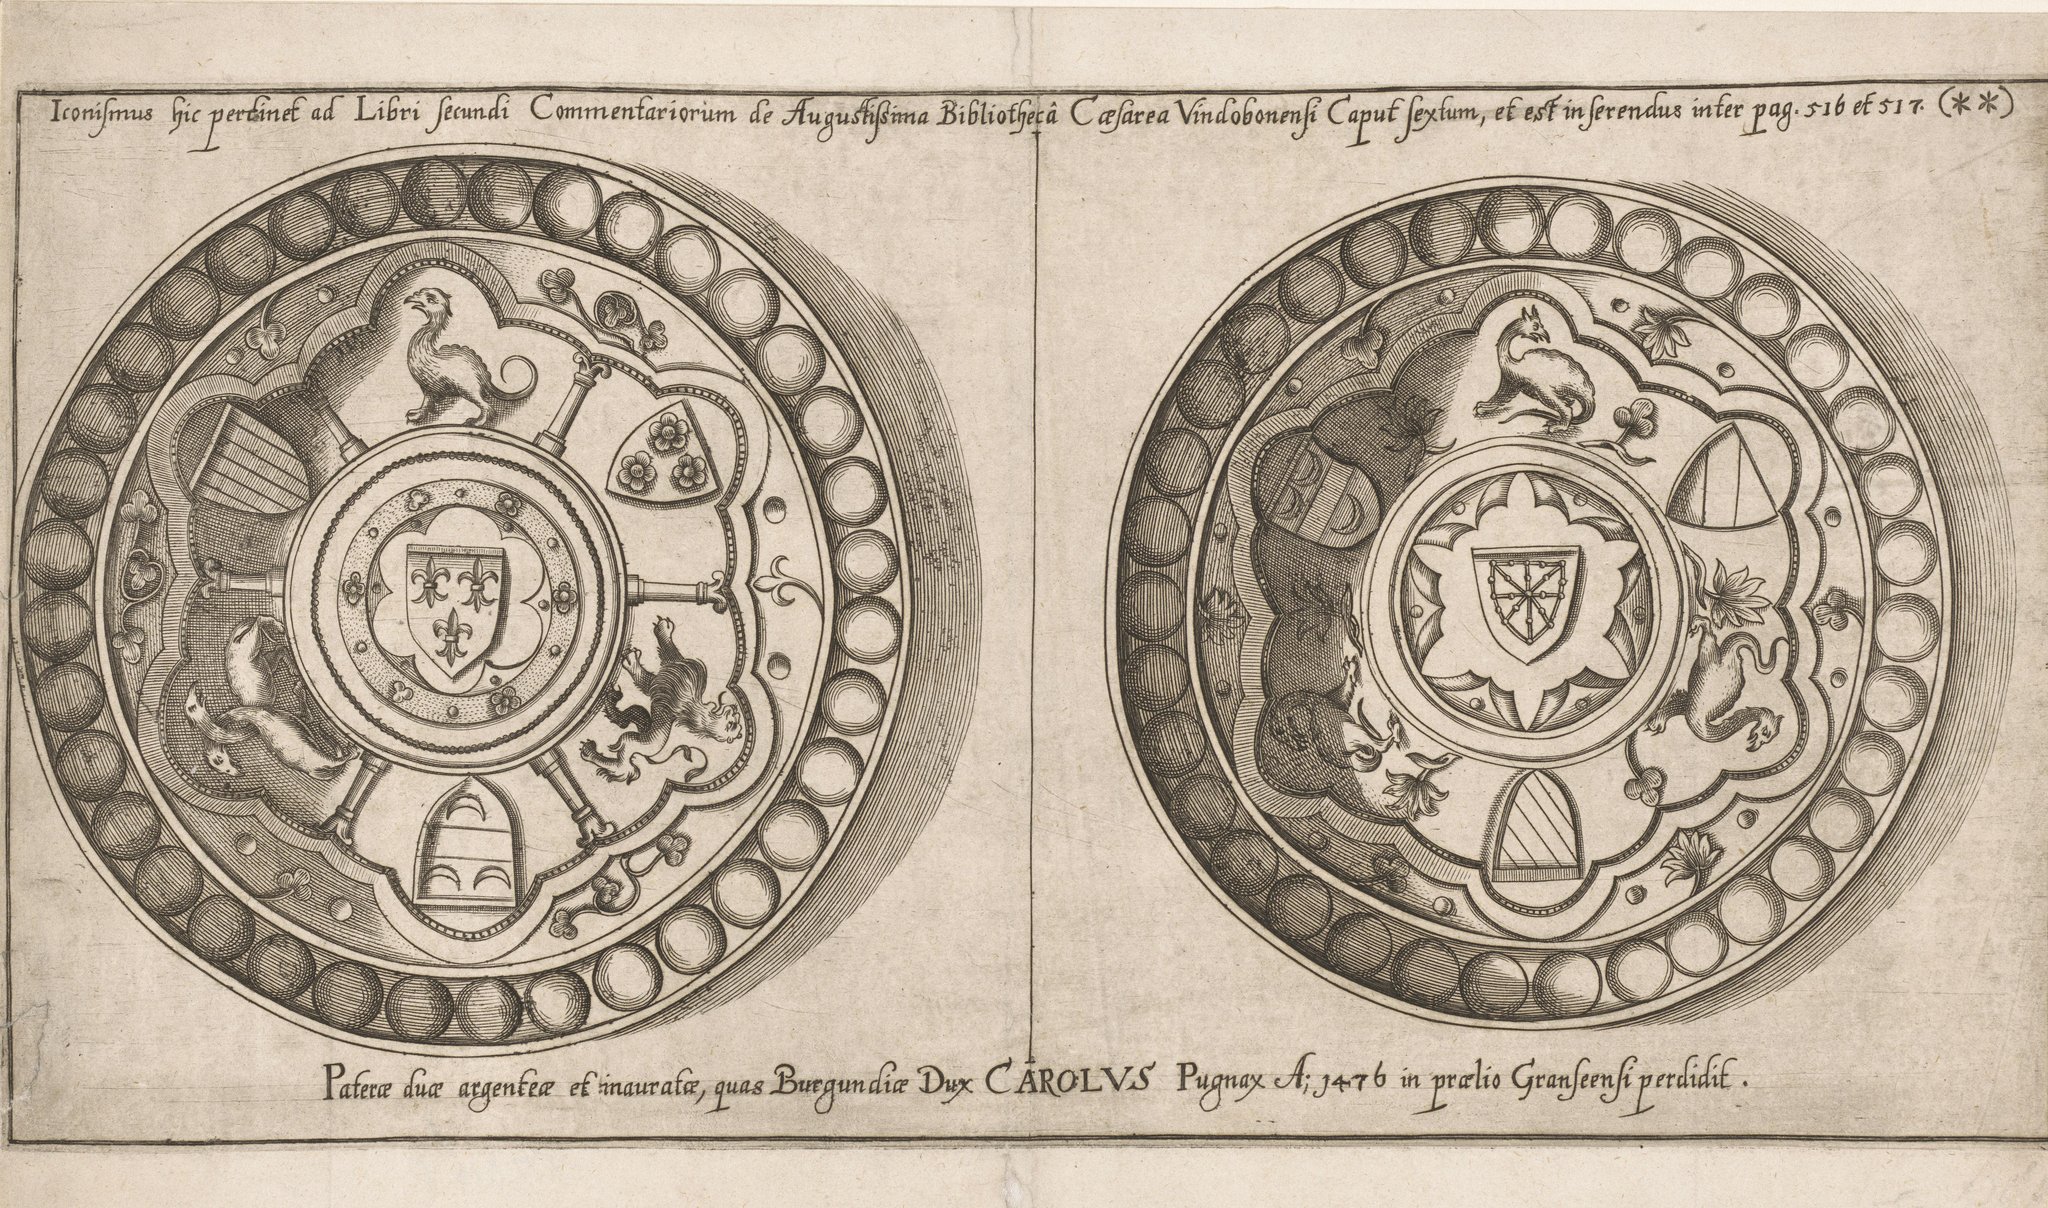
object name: historical object representation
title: Twee schotels van Karel de Stoute, 1476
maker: Anonymous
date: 1550-1599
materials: paper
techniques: engraving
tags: earl, charles the bold (duke of burgundy), dish, plate, saucer, burgundian netherlands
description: Niet in Frederik Muller; door het RPK toegevoegd nummer. Afkomstig uit een onbekend werk, met op de prent de verwijzing naar p. 516 en 517. Zie ook RP-P-1908-2197.